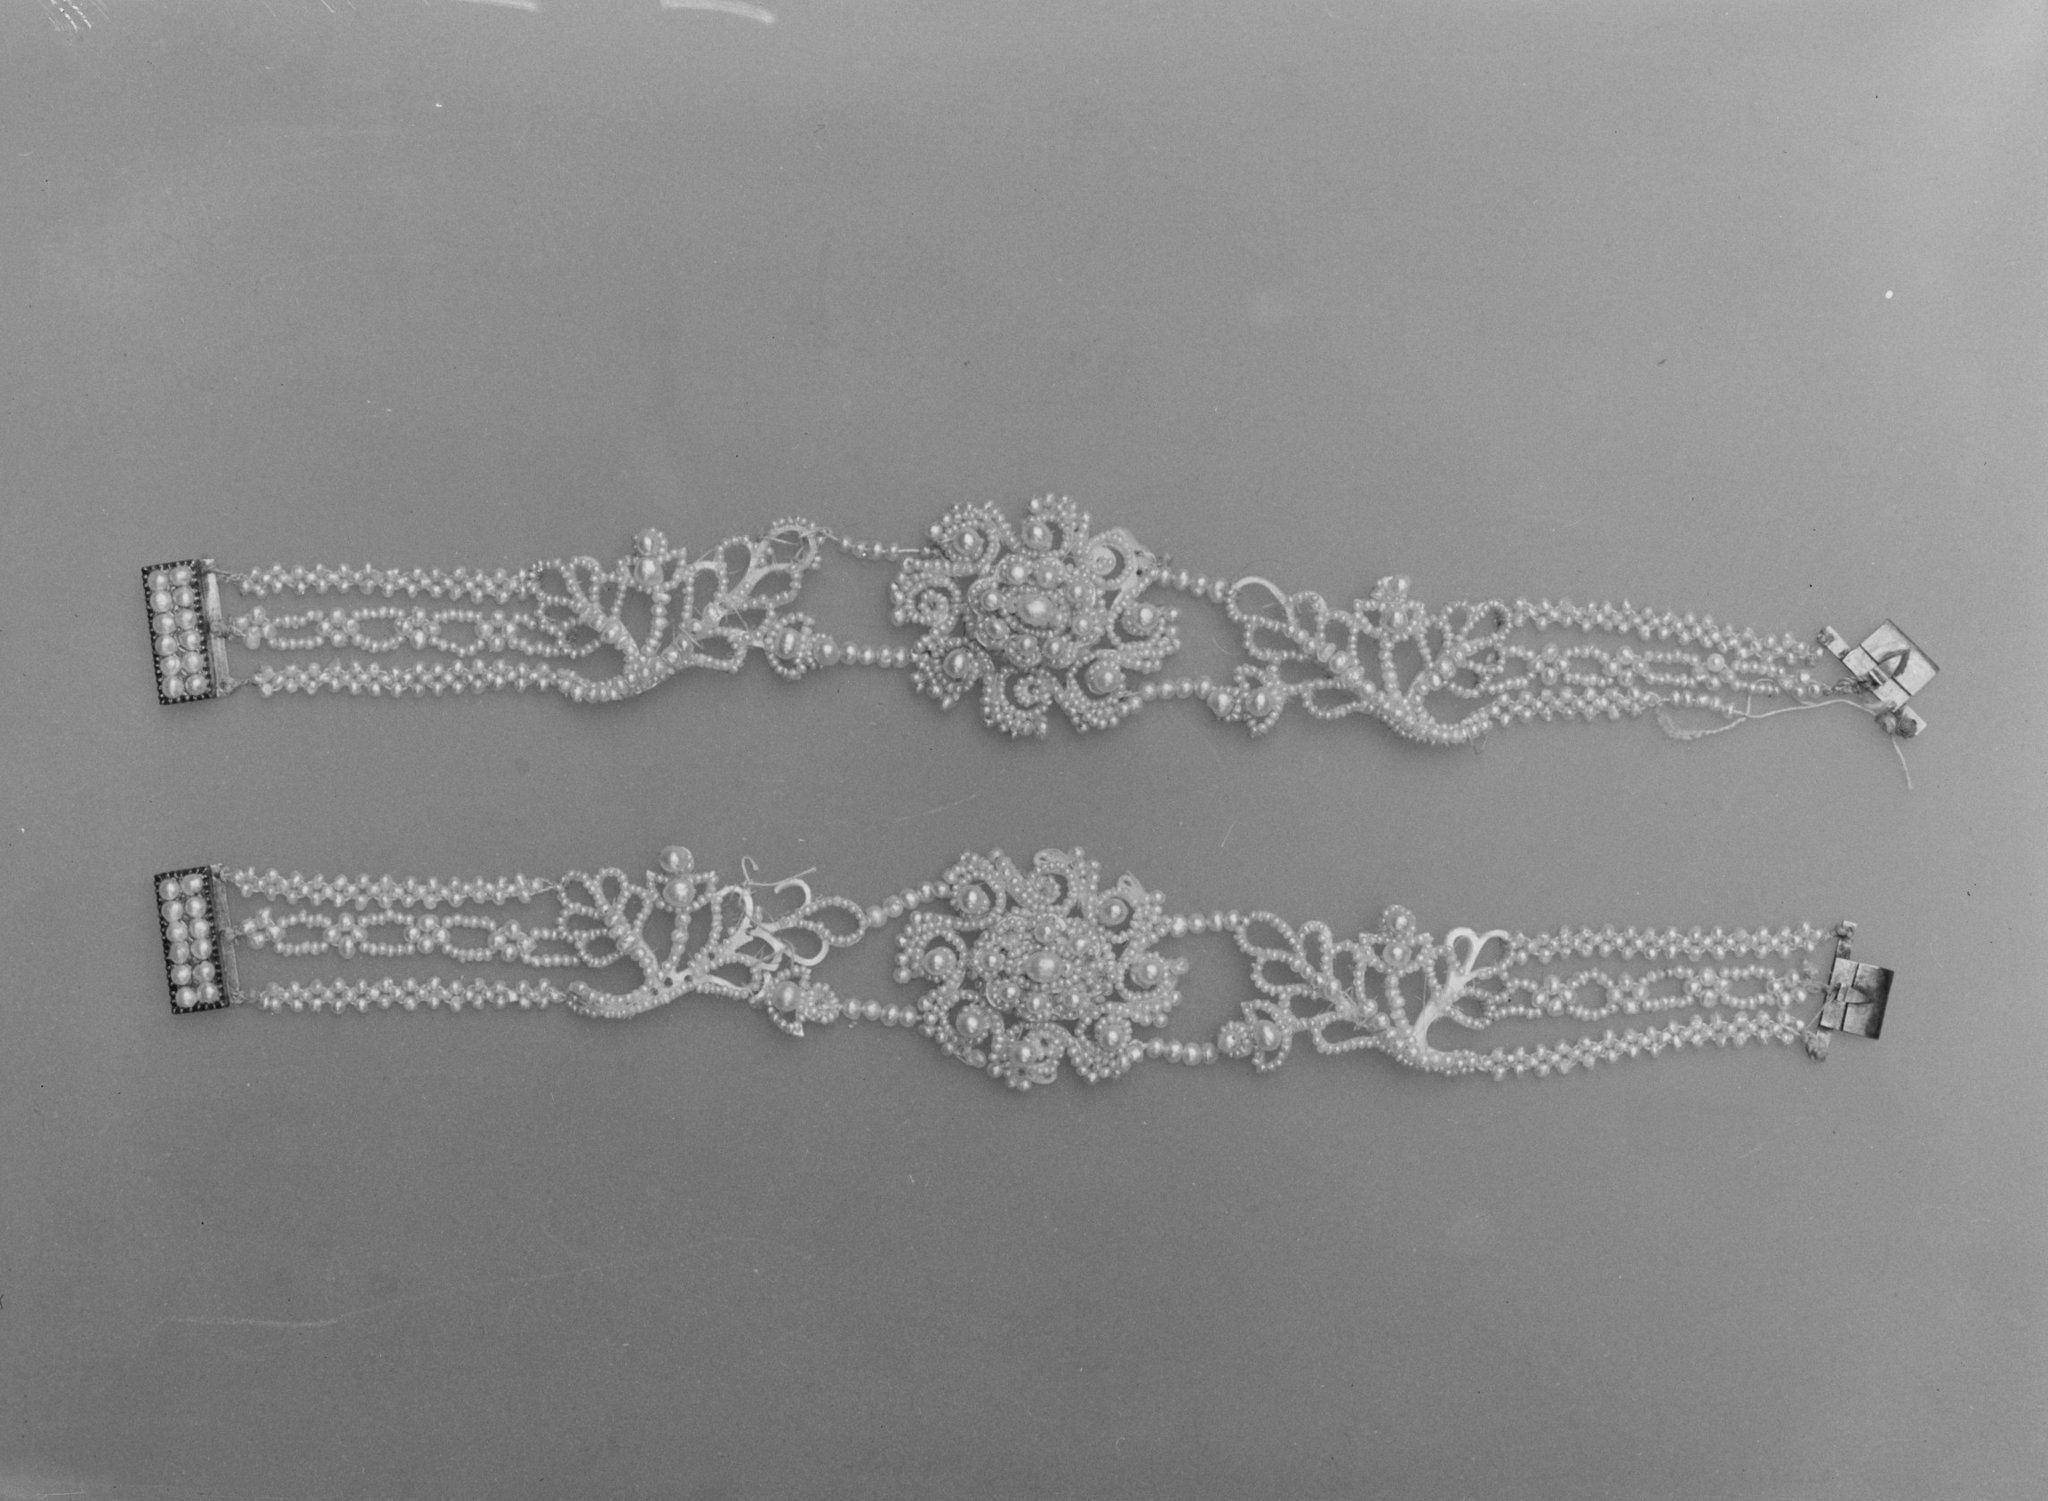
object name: bracelet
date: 1800-1900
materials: pearl